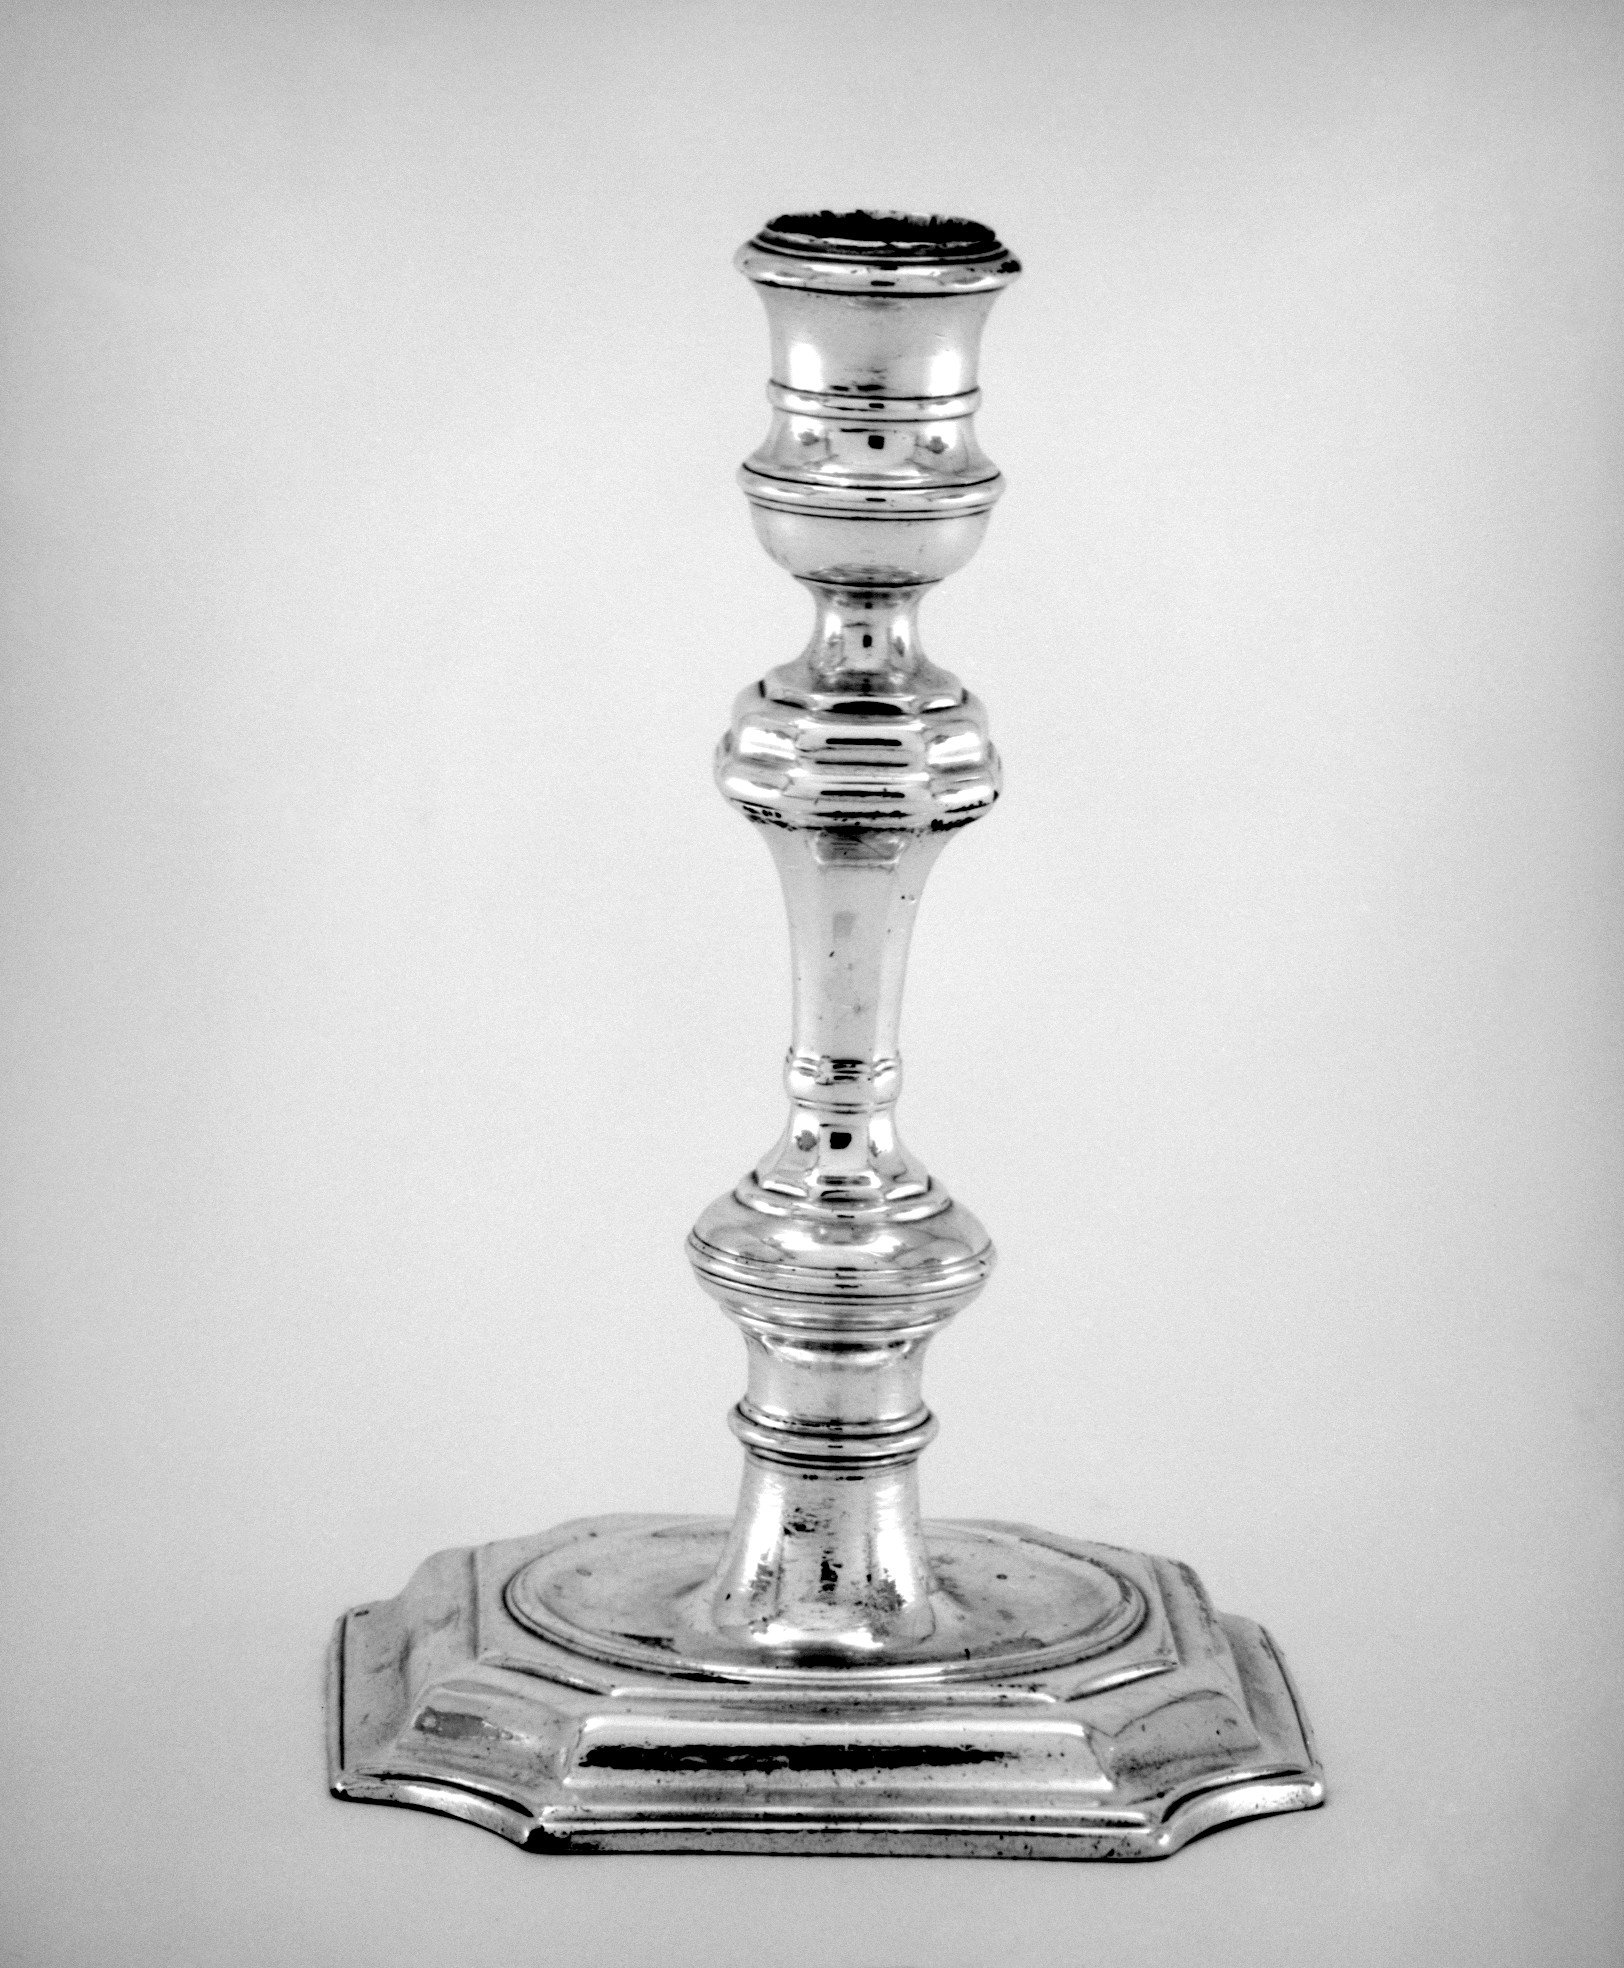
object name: candlestick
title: Pair of candlesticks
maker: paul de lamerie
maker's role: maker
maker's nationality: british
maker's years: 1688-1751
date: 1731-1732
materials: silver